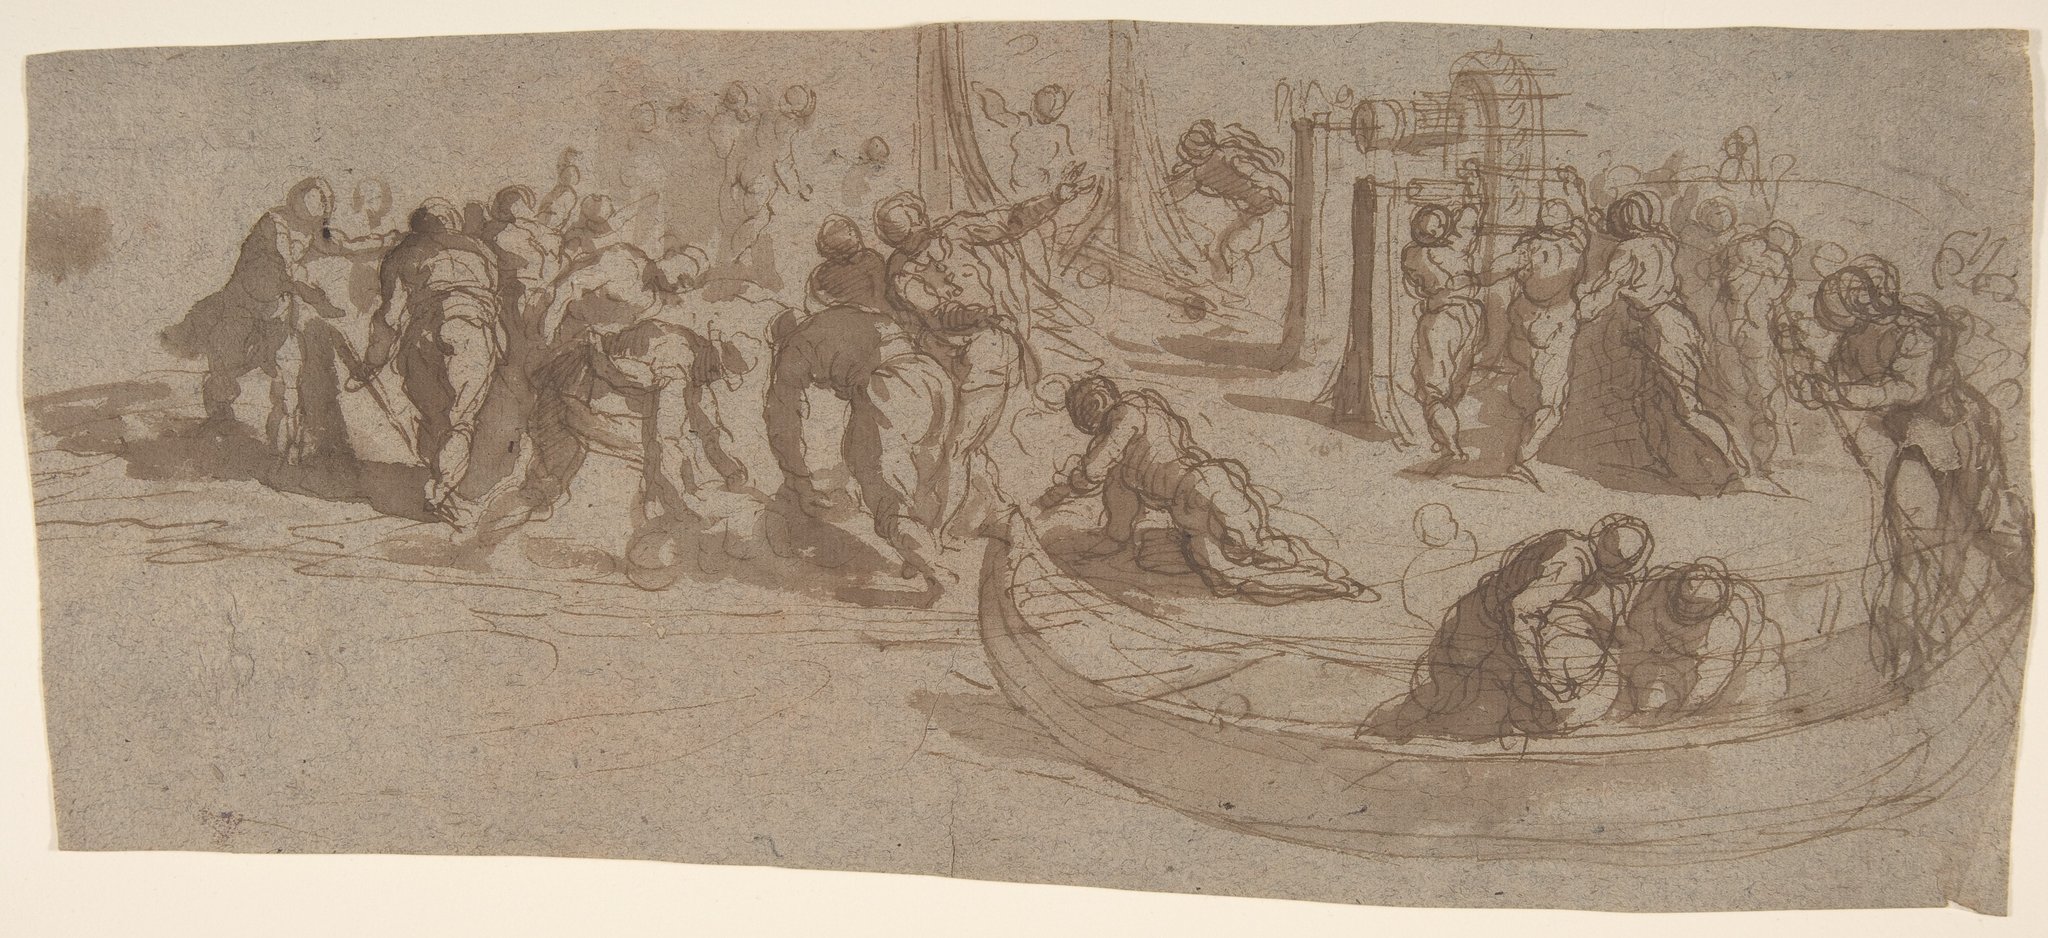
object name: drawing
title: Various Figure Groups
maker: jacopo palma the younger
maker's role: artist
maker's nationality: italian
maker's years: 1543-1628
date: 1548-1628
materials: ink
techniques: brush, pen, wash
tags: crowd,boats